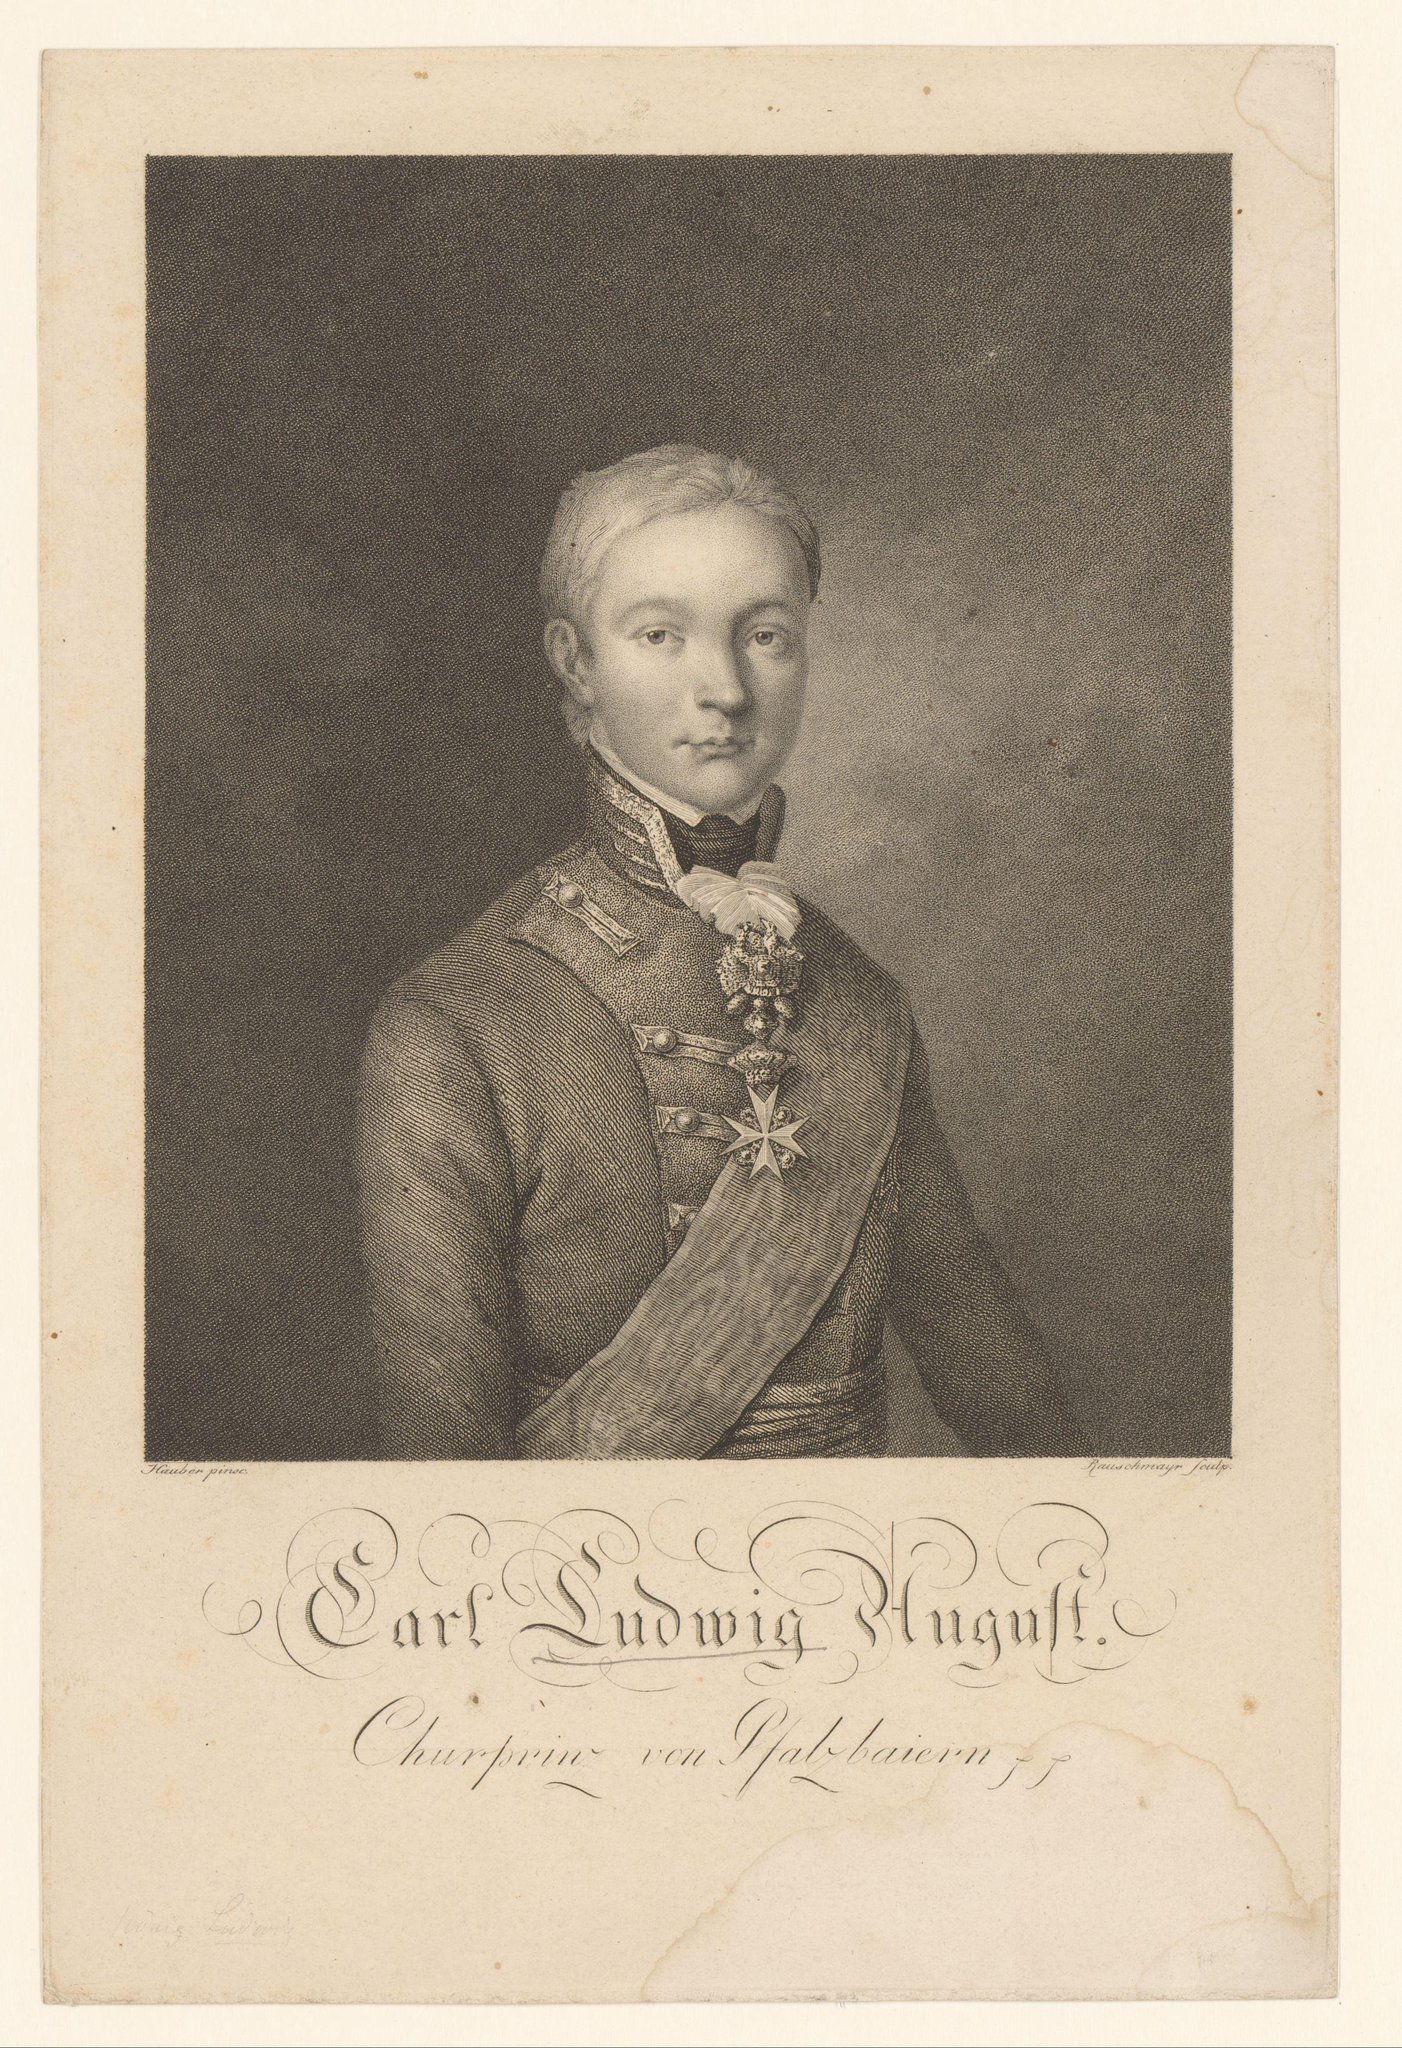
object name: print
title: Portret van Lodewijk I van Beieren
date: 1786-1815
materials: paper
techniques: engraving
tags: lodewijk i (koning van beieren), historical persons, medals and other marks of military honour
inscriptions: collector's mark: Lugt 2228